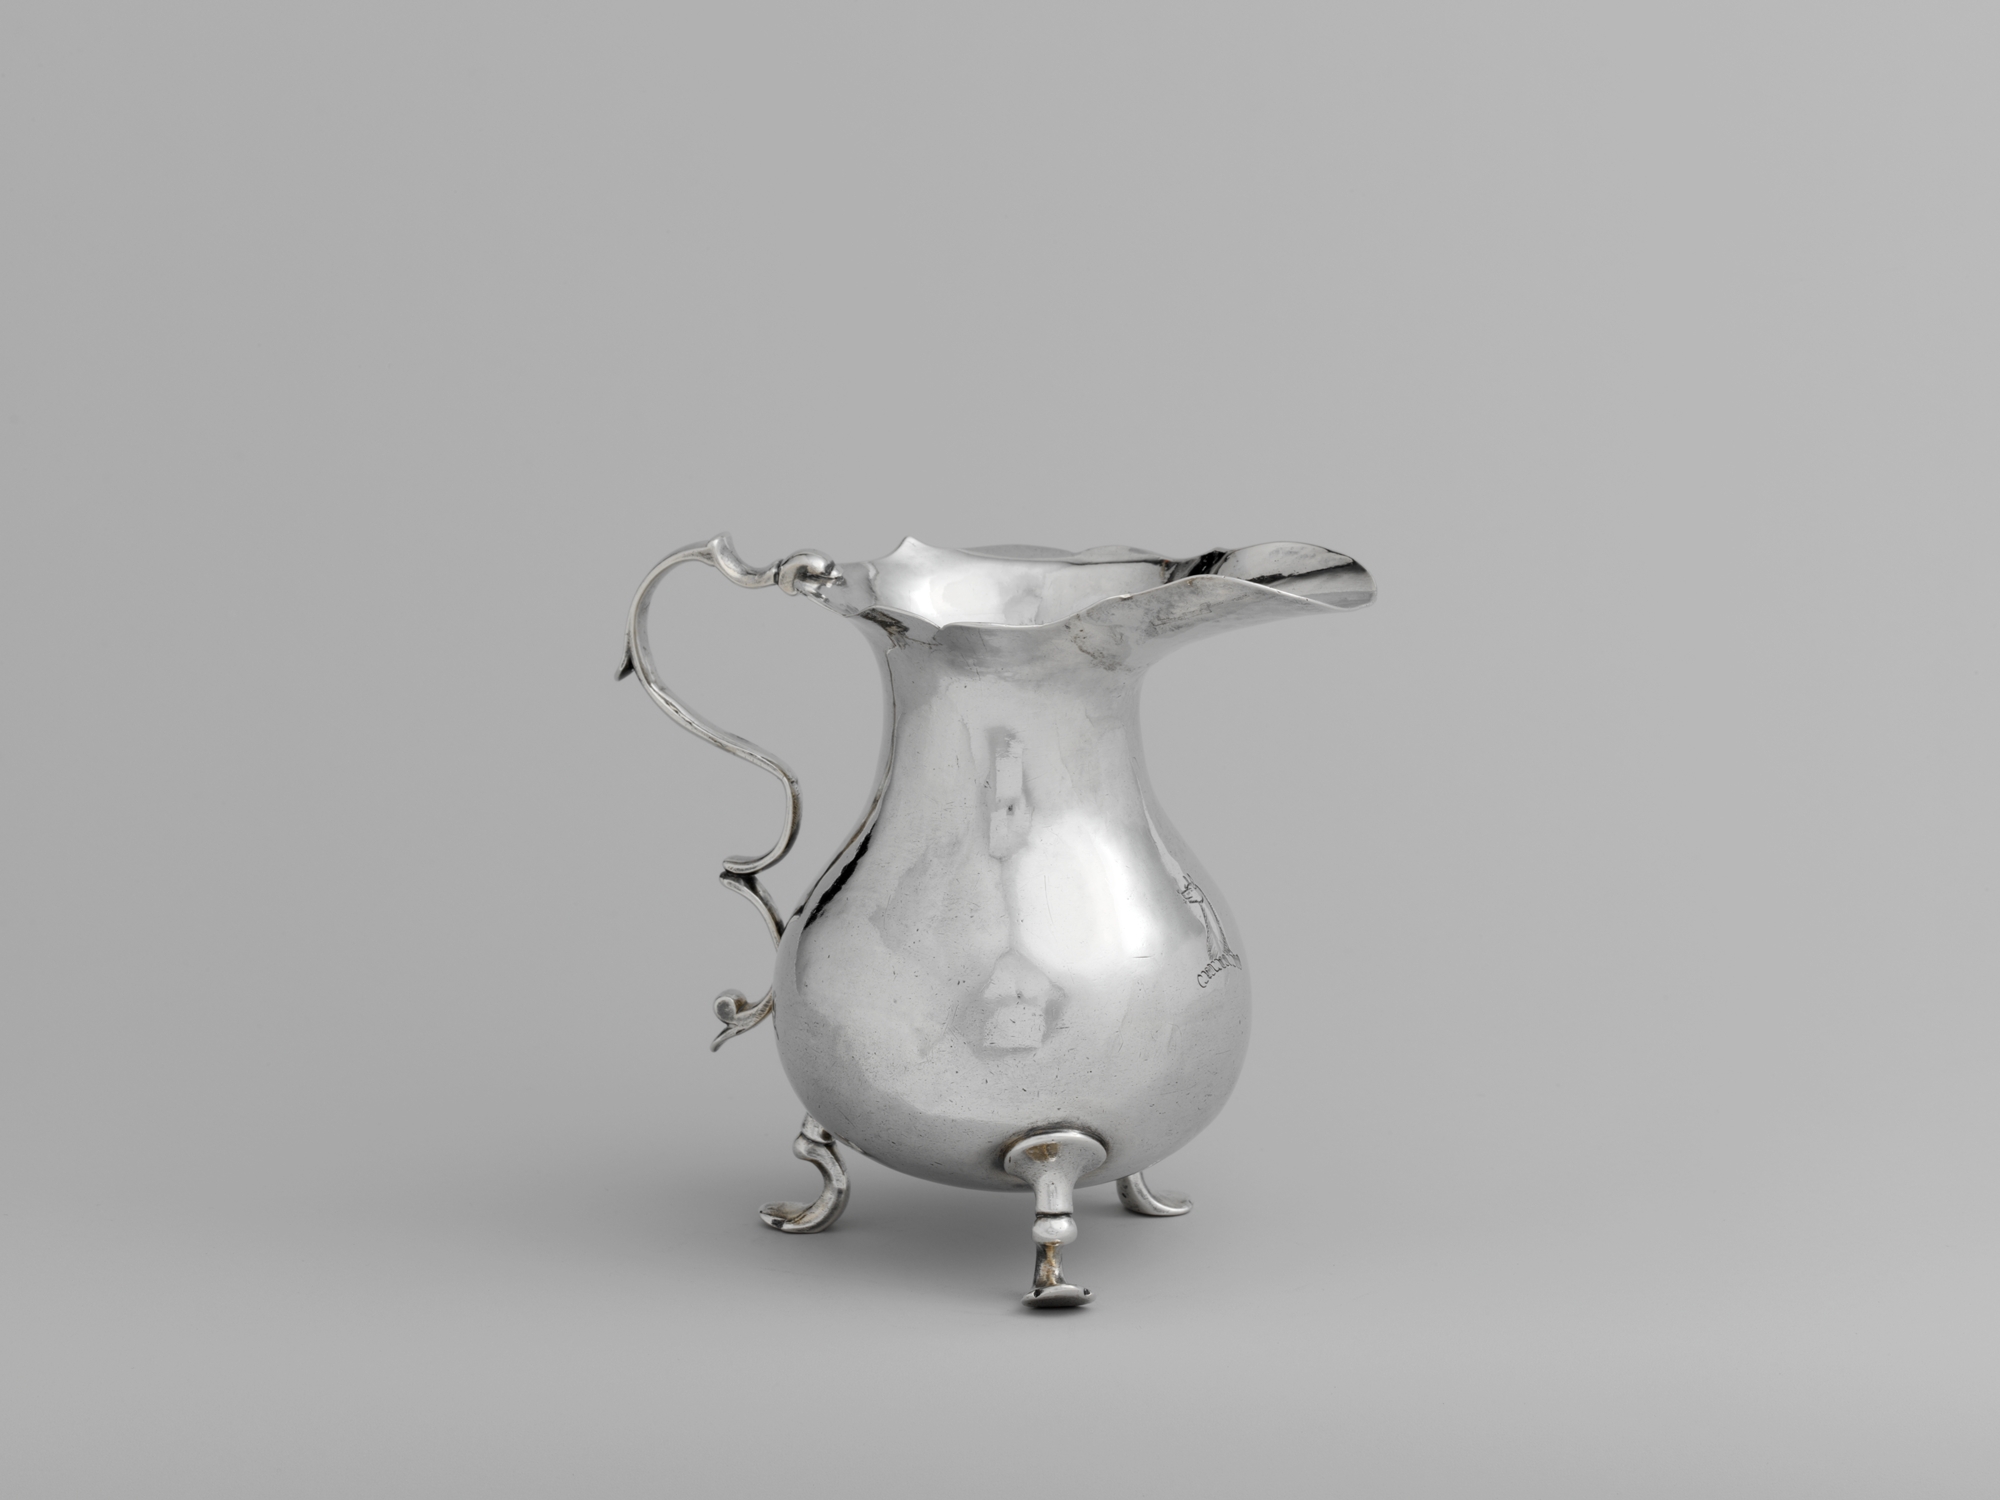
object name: cream pot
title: Creampot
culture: american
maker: joseph edwards jr.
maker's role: maker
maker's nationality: american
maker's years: 1737-1783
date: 1760-1780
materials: silver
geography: united states